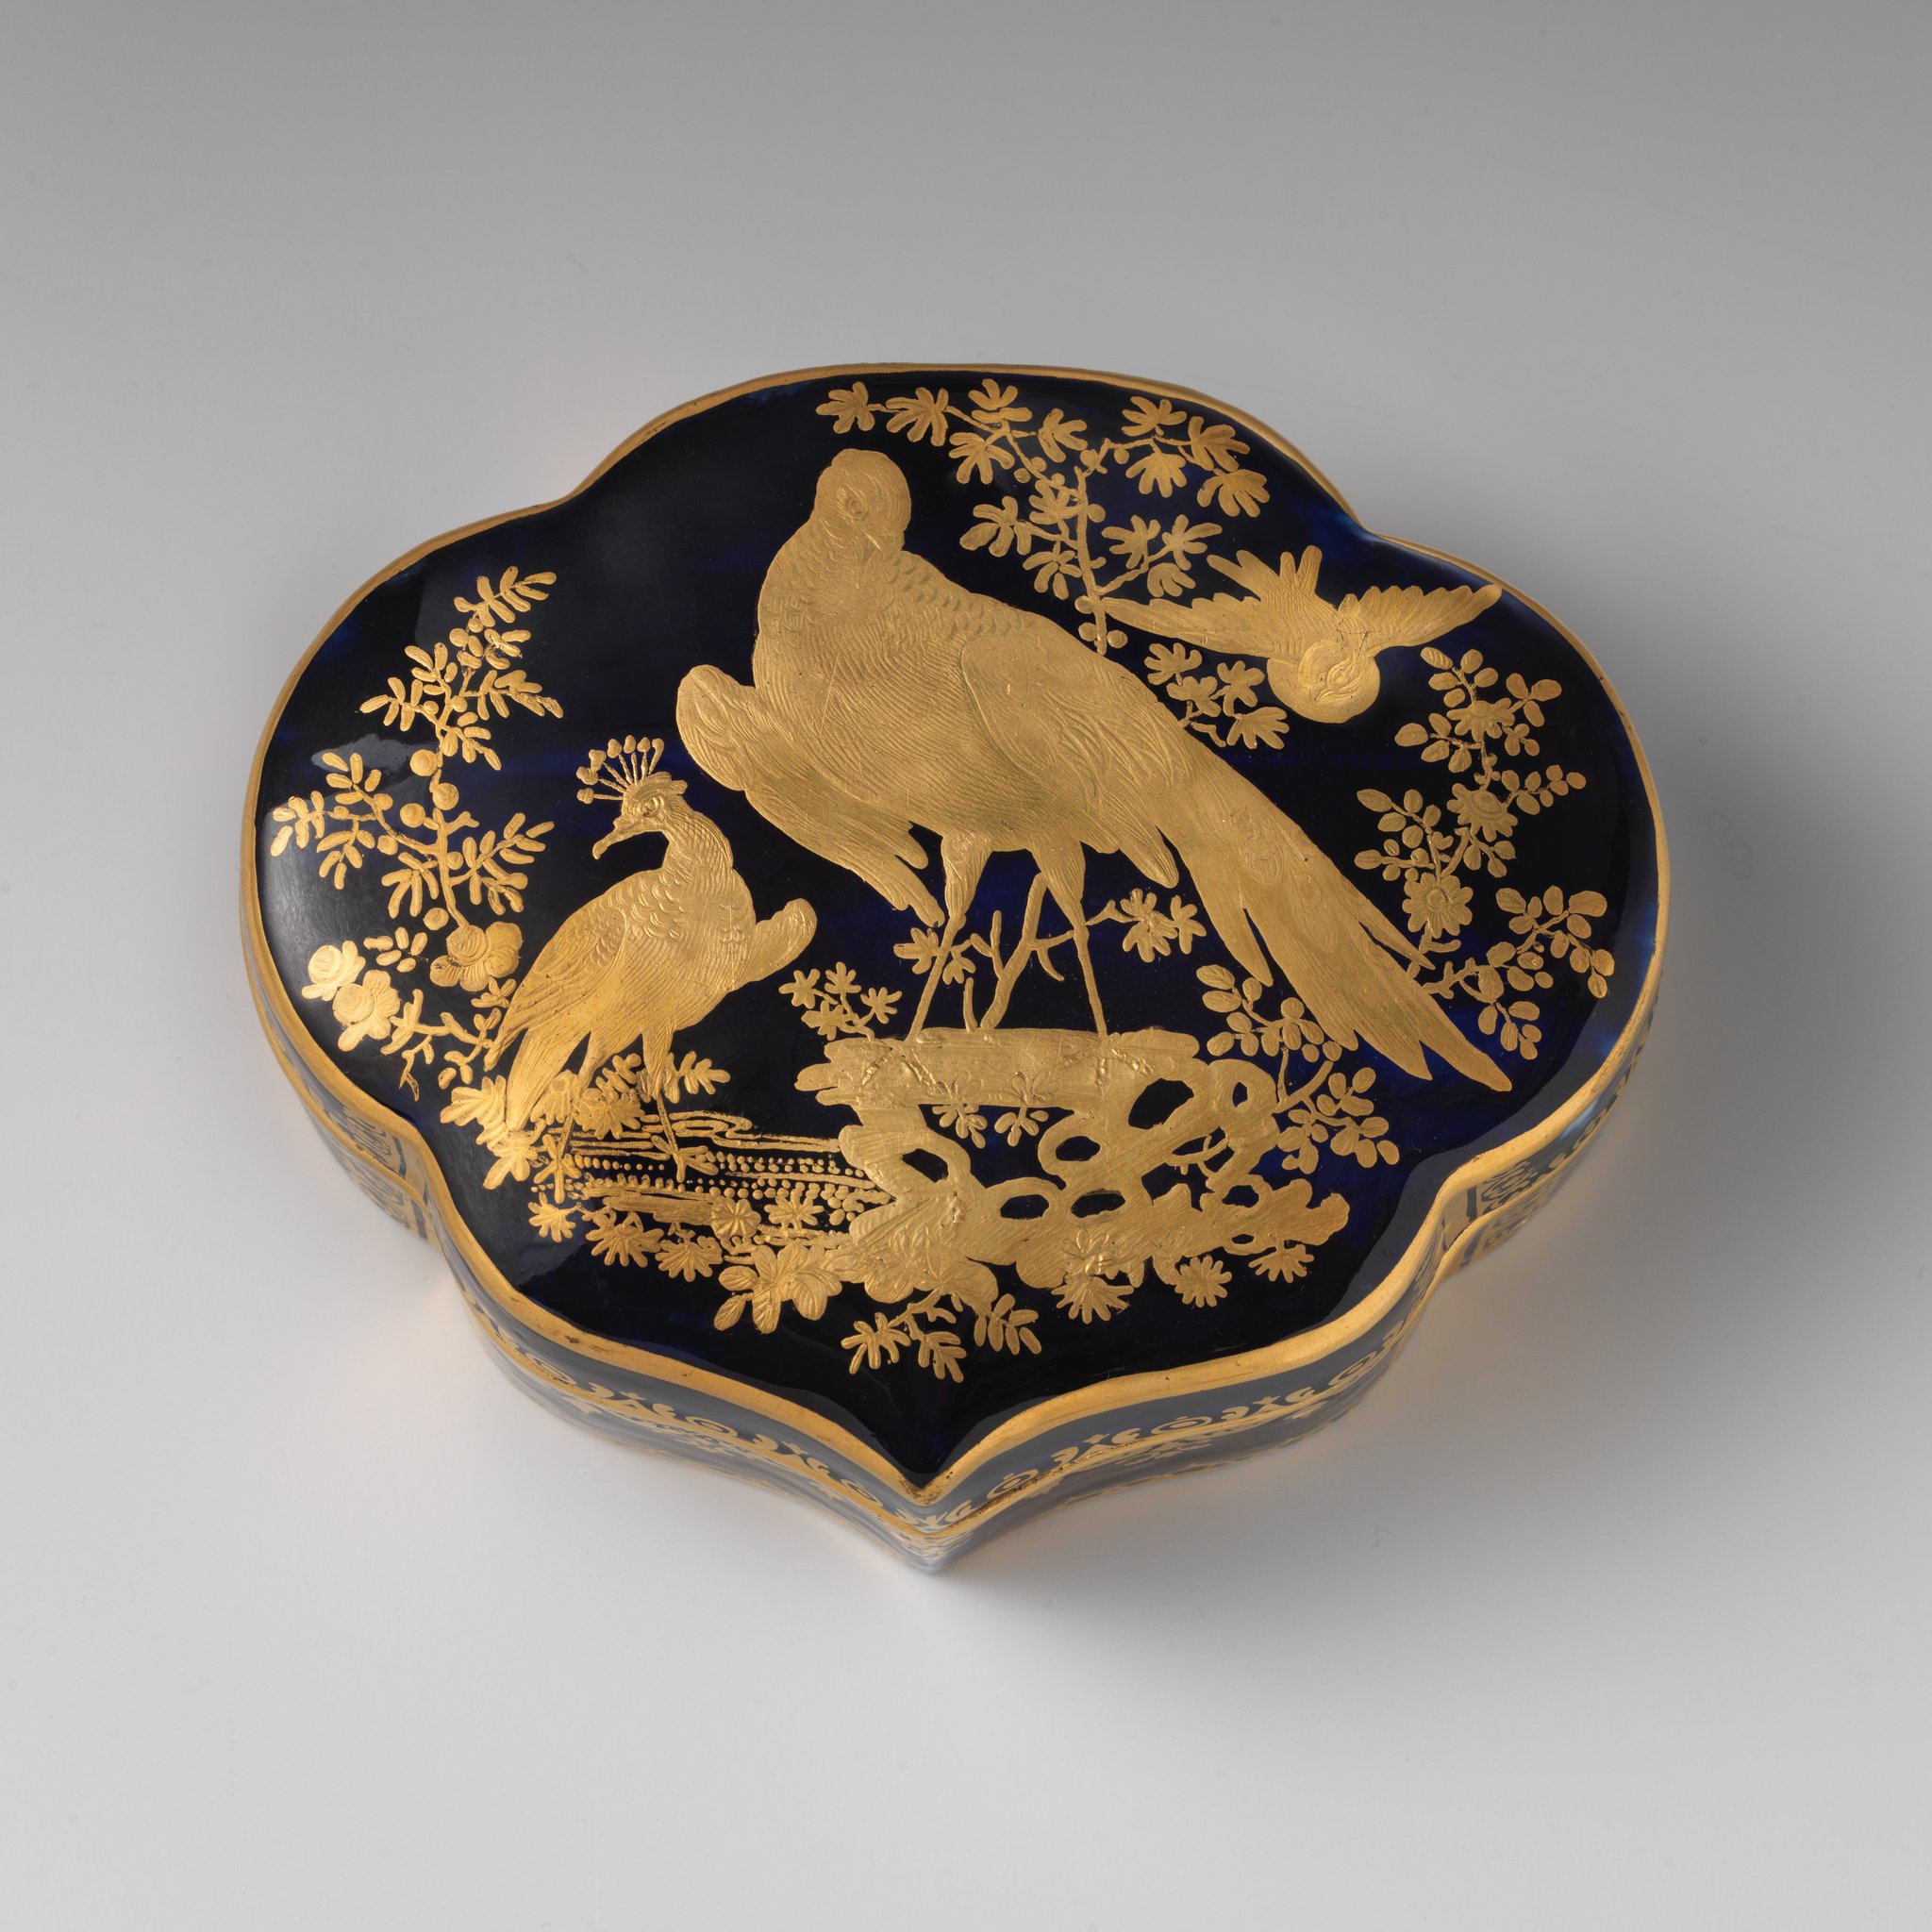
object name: toilet set containing box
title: Toilet set containing three smaller boxes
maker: chelsea porcelain manufactory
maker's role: factory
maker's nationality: british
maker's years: 1744-1784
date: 1761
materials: gold, soft paste porcelain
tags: birds,flowers